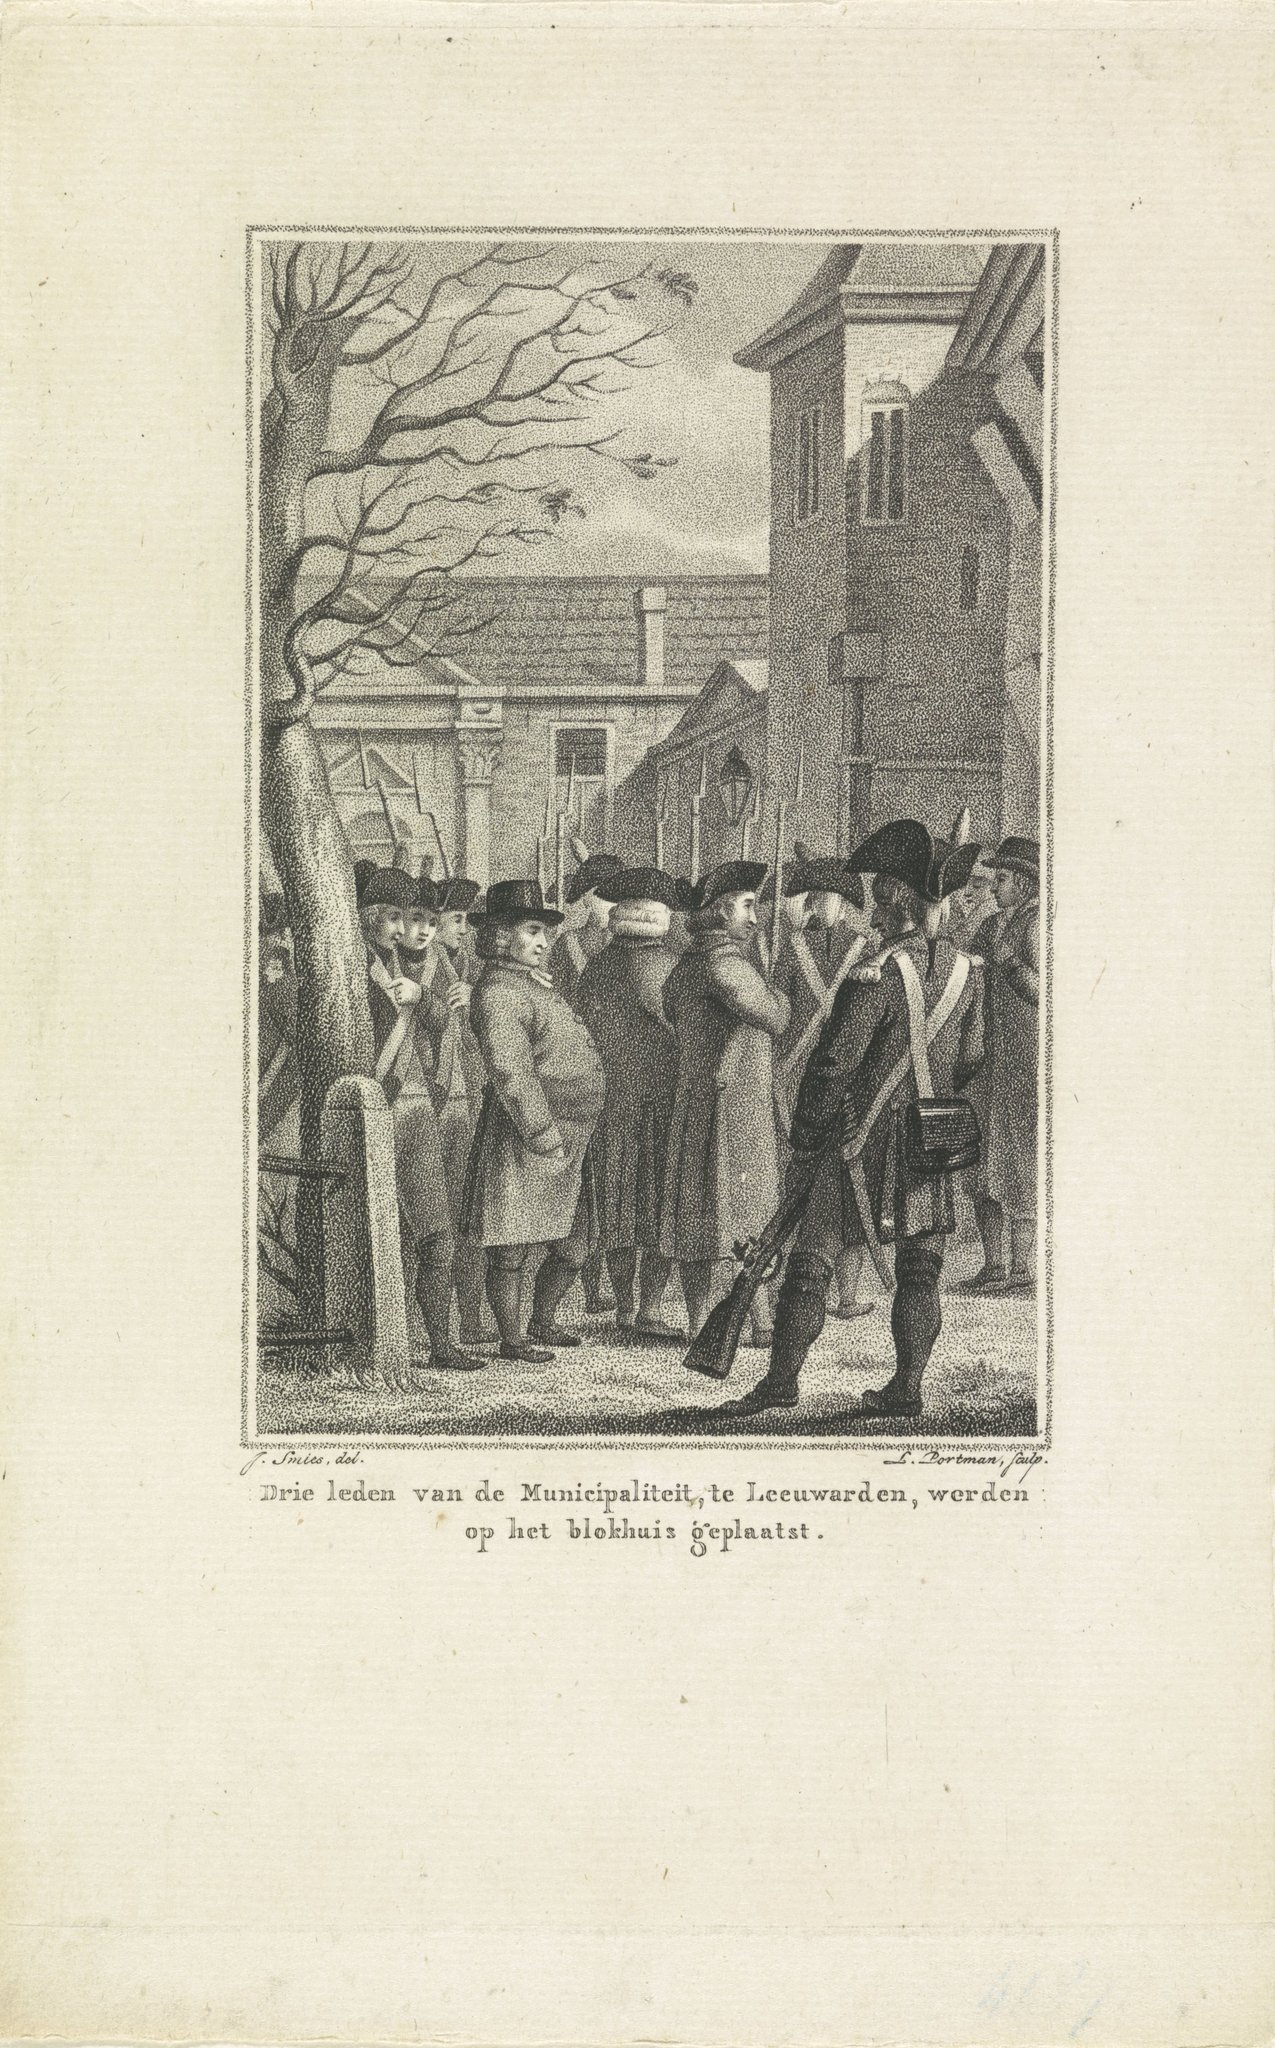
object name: print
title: Drie leden van de Municipaliteit, te Leeuwarden, werden op het blokhuis geplaatst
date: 1800-1801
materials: paper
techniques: stippled etching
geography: netherlands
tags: arrest (of criminal)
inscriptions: collector's mark: Lugt 2228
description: Gebruikt als illustratie in: Cornelis Zillesen, Geschiedenis der Vereenigde Nederlanden, nevens de voornaamste gebeurtenissen in Europa. 6 dln, 1798-1802. Den Haag: J.C. Leeuwestijn, dl. V (1801).